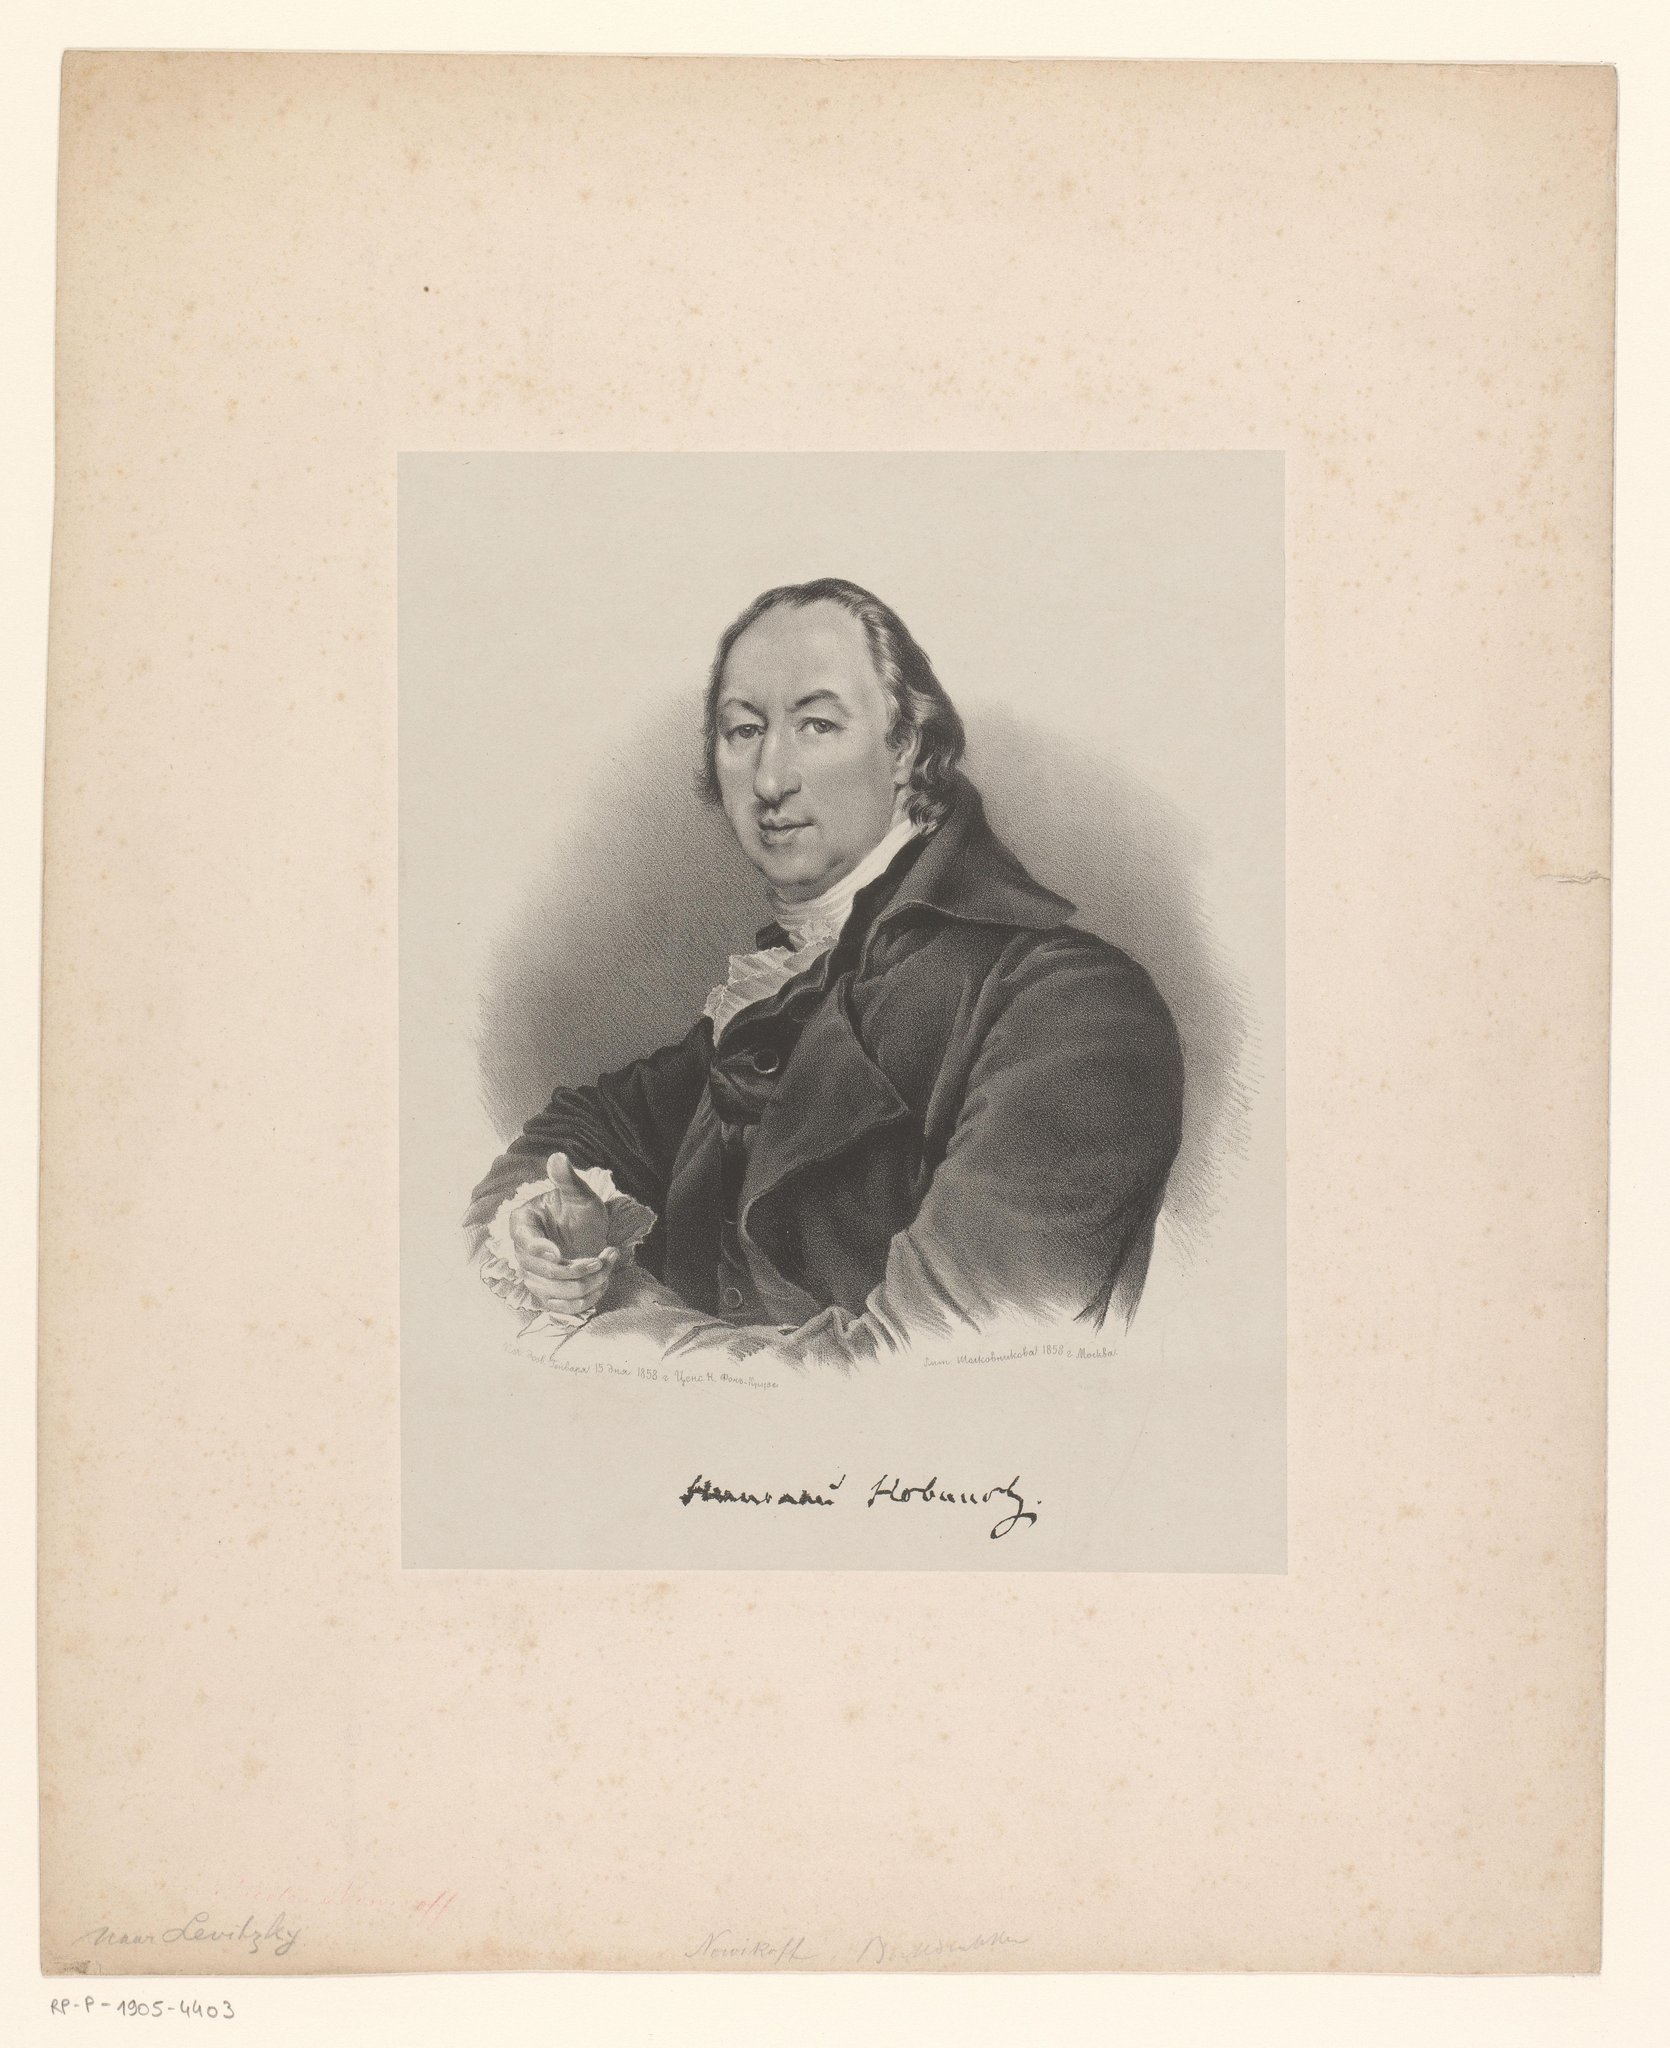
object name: print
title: Portret van een onbekende man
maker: Anonymous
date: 1858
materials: paper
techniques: lithograph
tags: adult man, historical persons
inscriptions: collector's mark: Lugt 2228